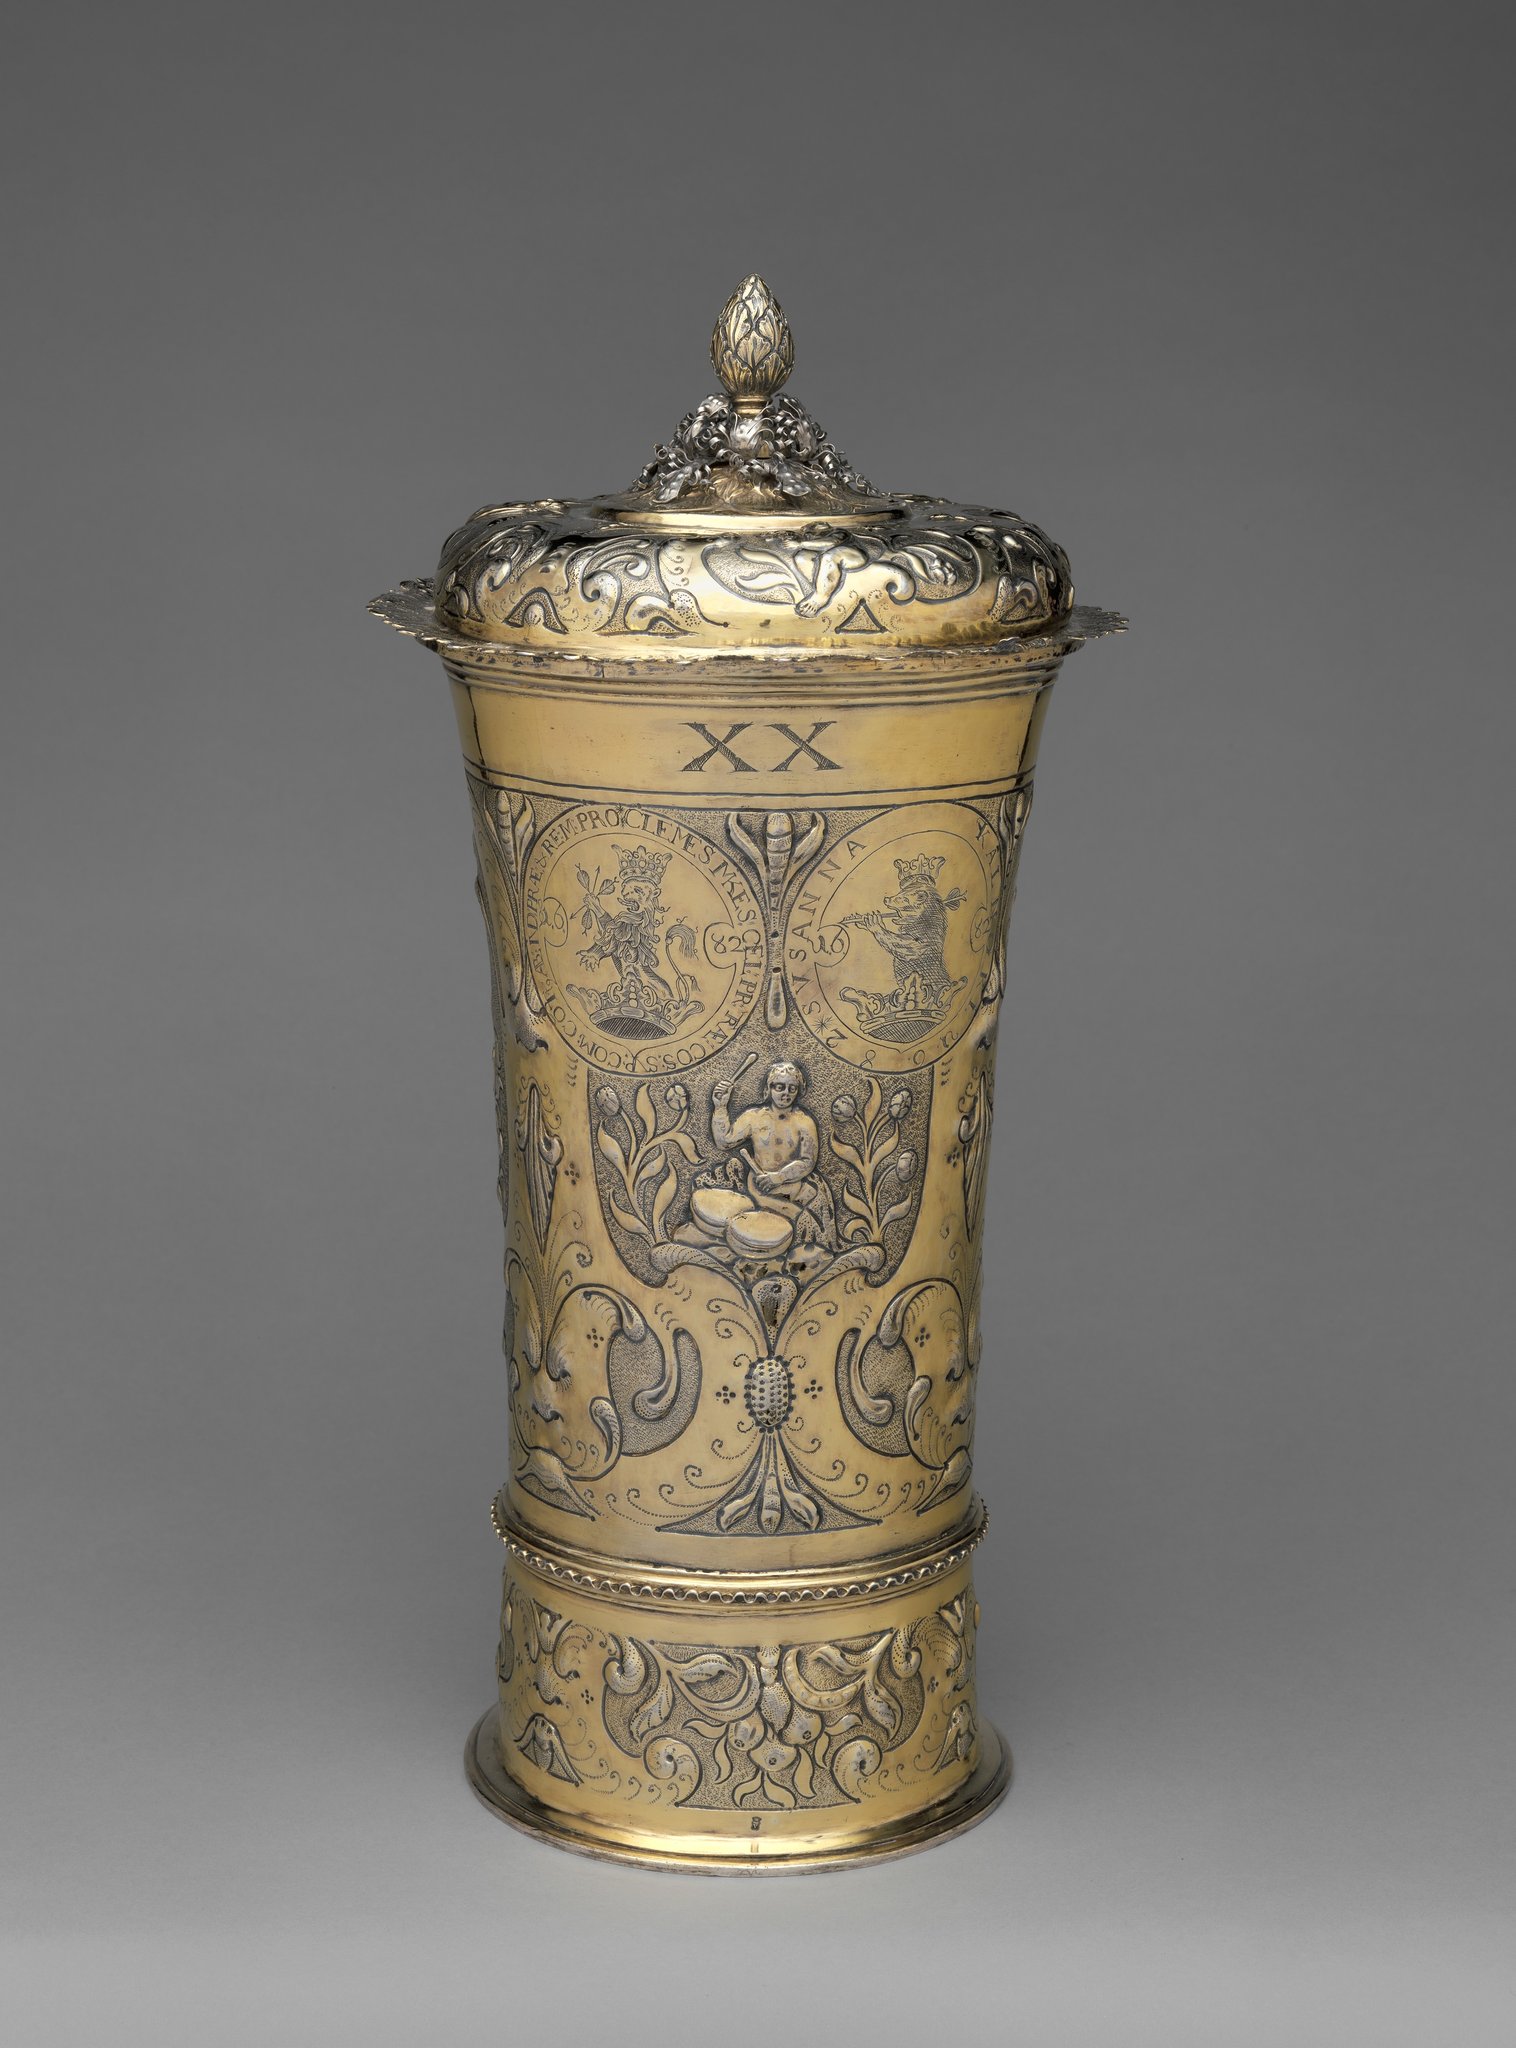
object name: beaker with cover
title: Footed beaker with cover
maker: johannes (hans) mautner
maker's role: maker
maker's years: 1594-1694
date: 1682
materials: gilt silver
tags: men,drums,lutes